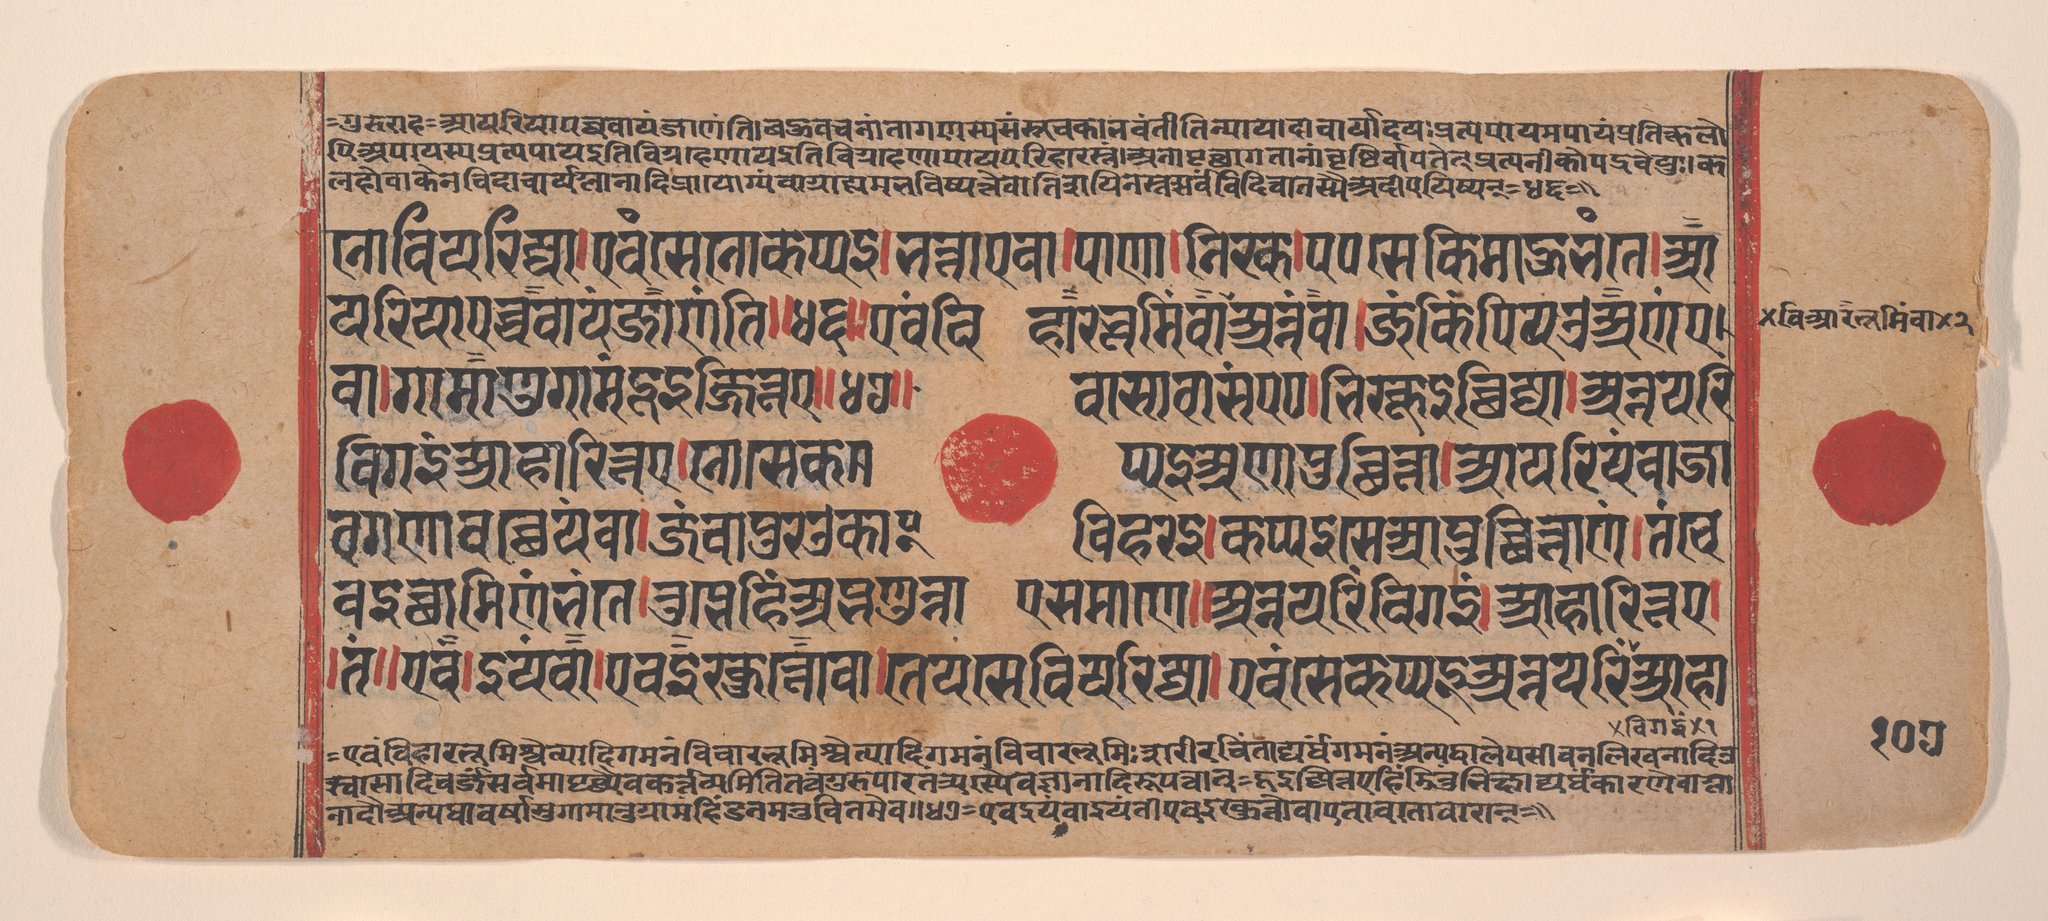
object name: folio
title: Page from a Dispersed Kalpa Sutra (Jain Book of Rituals)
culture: indian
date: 1401-1500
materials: gold, ink, paper, watercolor